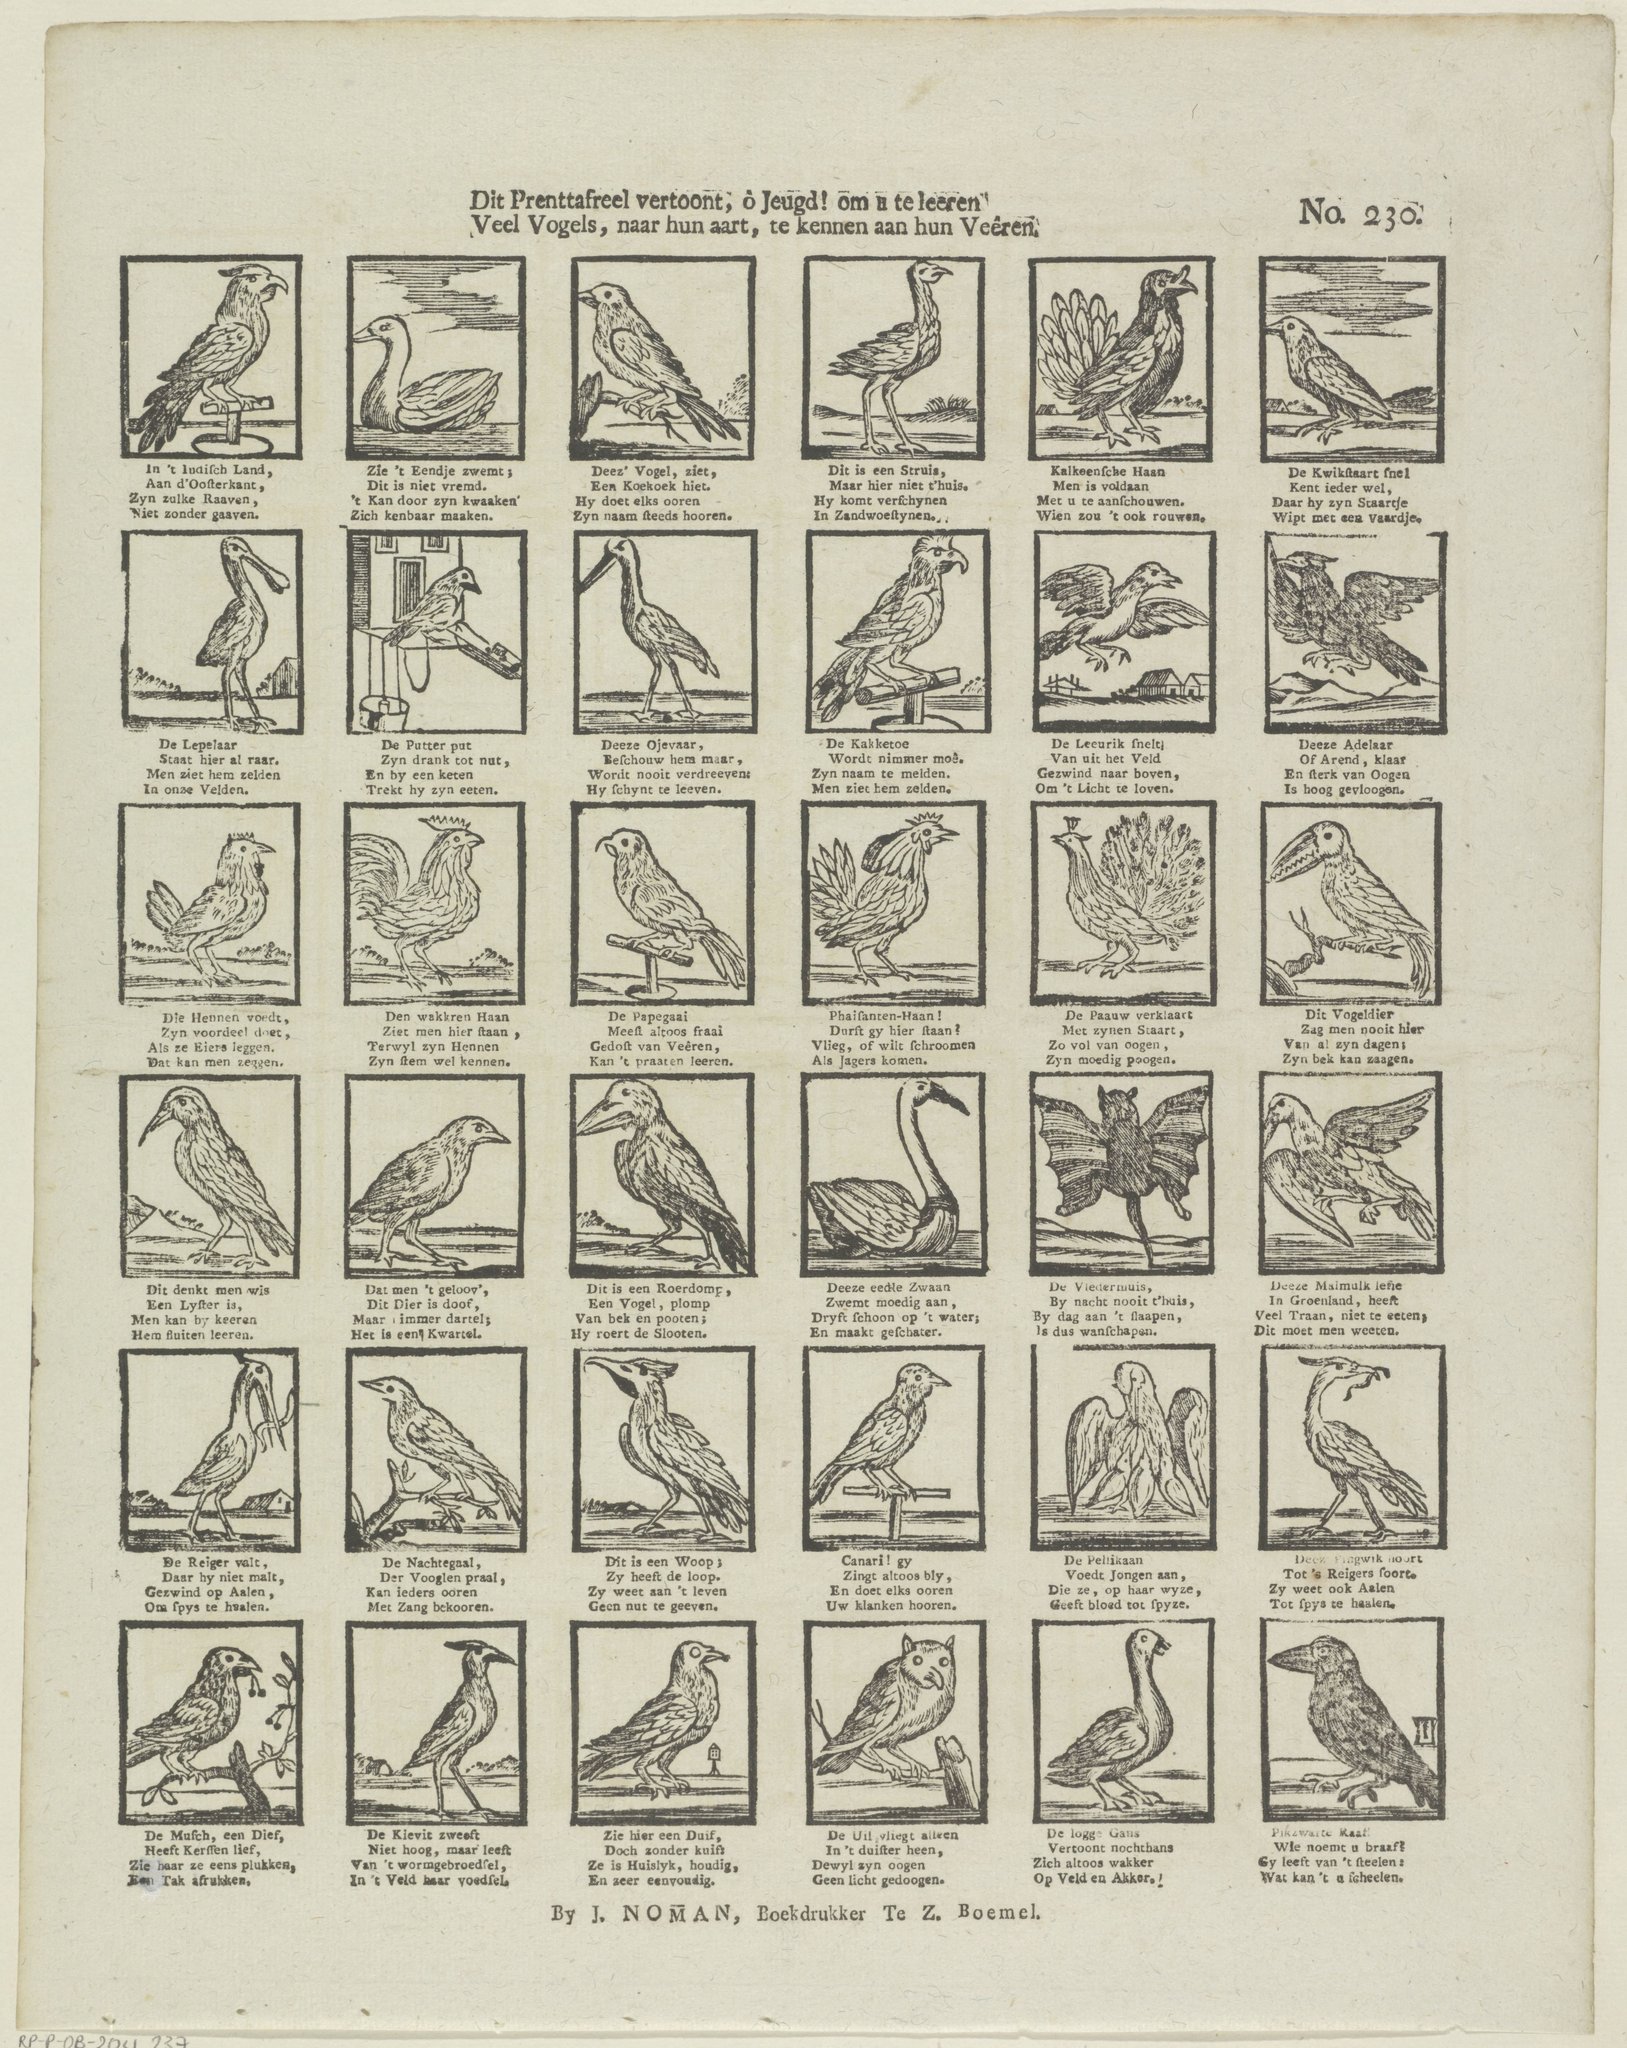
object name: print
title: Dit prenttafreel vertoont, ô jeugd! om u te leeren / Veel vogels, naar hun aart, te kennen aan hun veêren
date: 1806-1830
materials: paper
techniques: letterpress printing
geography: netherlands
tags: flying mammals: bat, birds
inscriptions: collector's mark: Lugt 2760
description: Blad met 36 voorstellingen van verschillende vogels en een vleermuis. Onder elke afbeelding een vierregelig vers. Genummerd rechtsboven: No. 230.